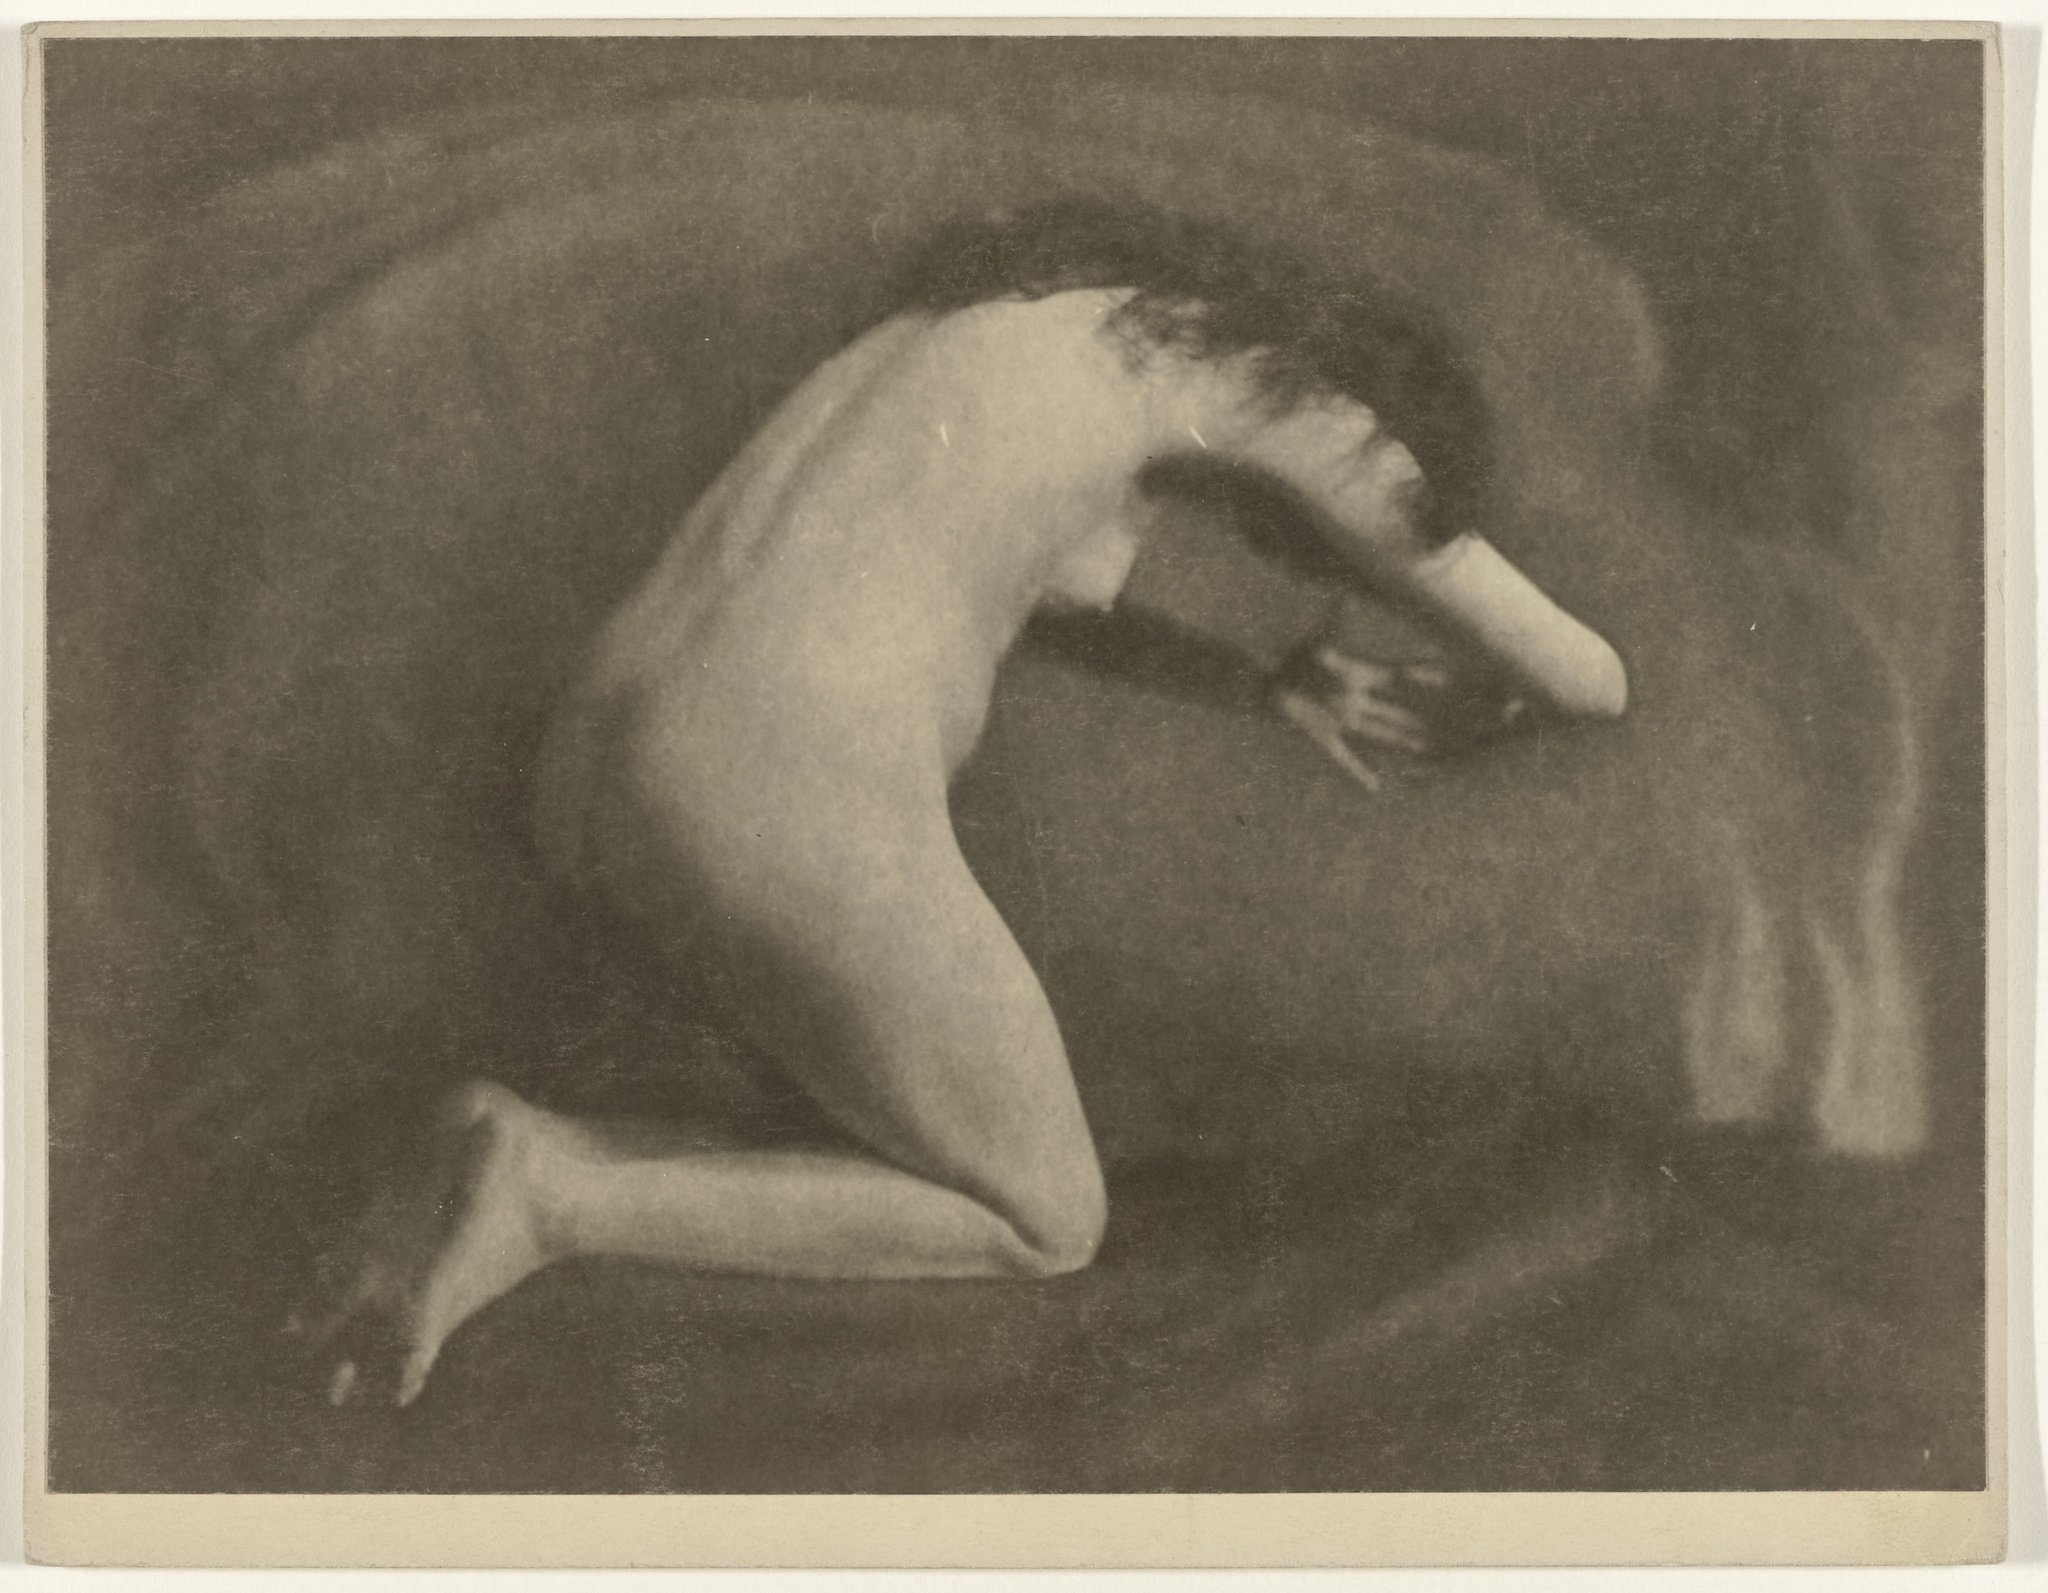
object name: photograph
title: Knielend vrouwelijk naakt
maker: jacob merkelbach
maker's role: fotograaf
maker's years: 1877-1942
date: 1913-1942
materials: photographic support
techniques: gelatin silver print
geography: amsterdam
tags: amsterdam, mies rosenboom-merkelbach, the (nude) human figure; 'corpo humano' (ripa) - aa - female human figure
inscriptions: inscription: ‘J. Merkelbach A'dam. gomdruk. foto mevr. m. Rosenboom Merkelbach’